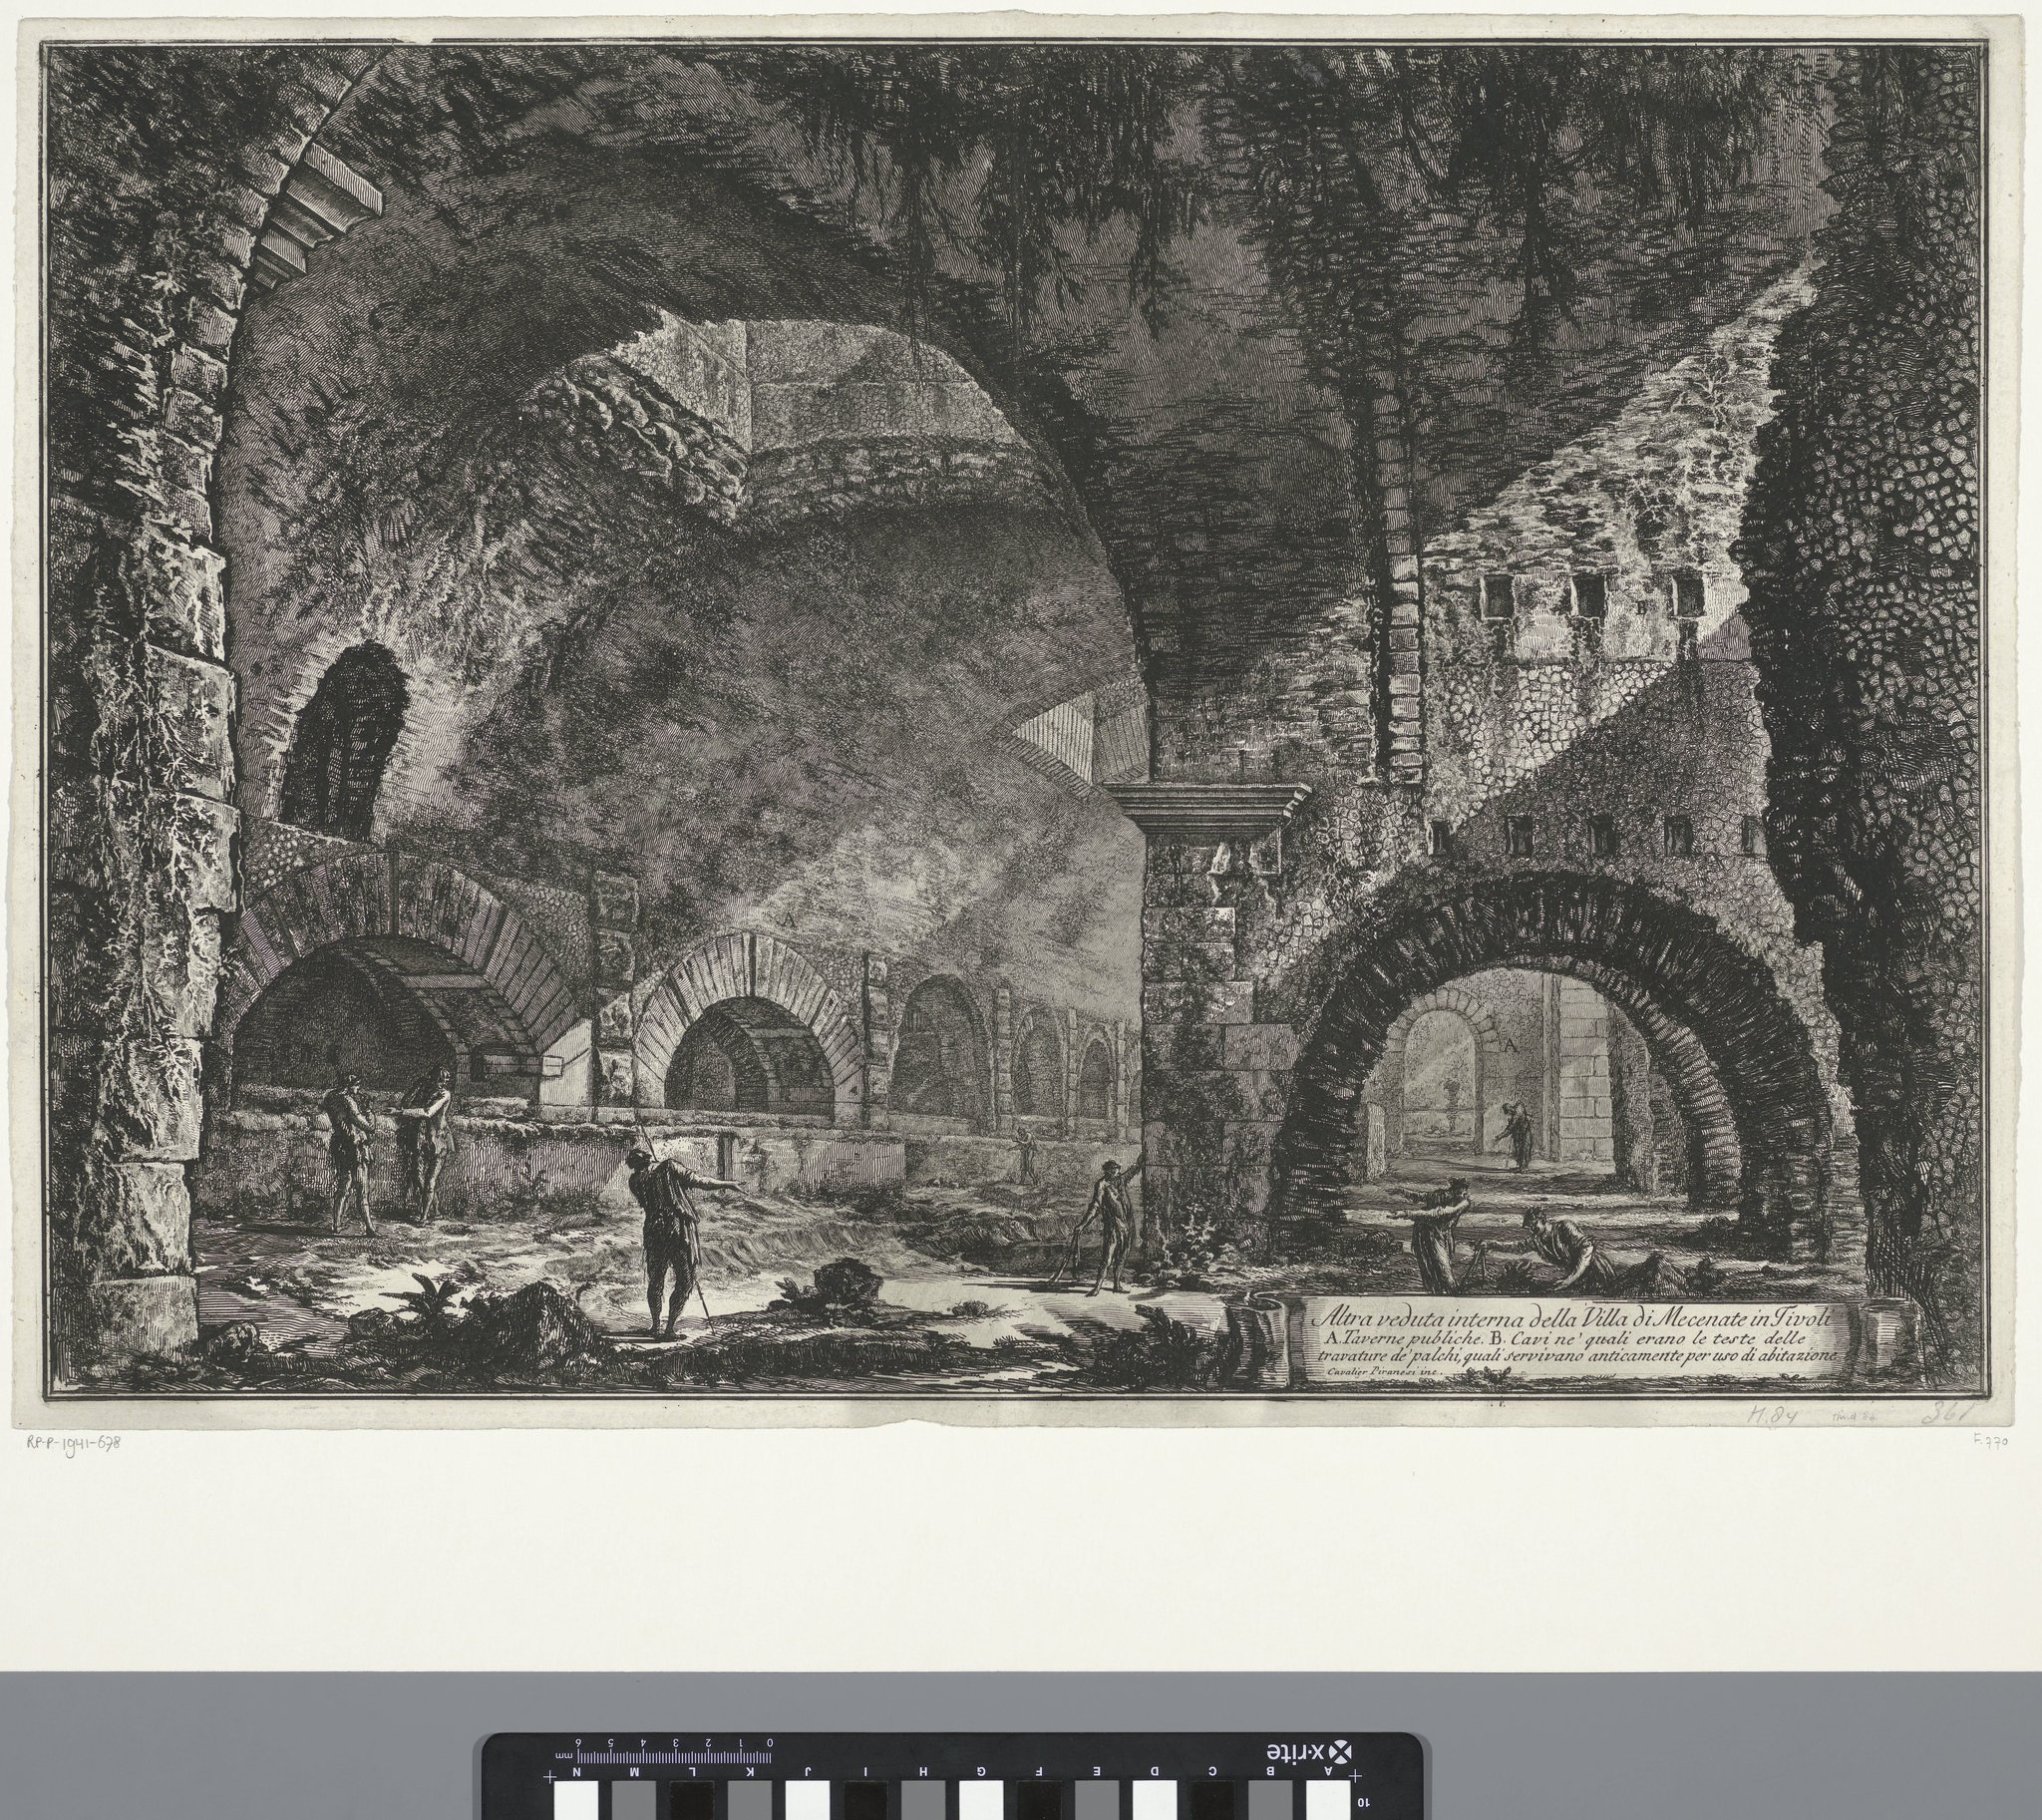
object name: print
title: Gezichten op Rome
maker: giovanni battista piranesi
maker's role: designer, draughtsman, print maker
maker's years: 1720-1778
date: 1748-1778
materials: paper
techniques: etching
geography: rome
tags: ruin of a building ~ architecture, landscape with ruins, villa, temple of hercules victor, tivoli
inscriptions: collector's mark: Lugt 2228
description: Deze prent maakt deel uit van de serie 'Vedute di Roma'. Piranesi werkte aan deze 135 platen tellende serie tussen 1748 en zijn dood in 1778. Francesco Piranesi voegde later nog twee prenten toe aan de reeks van zijn vader.